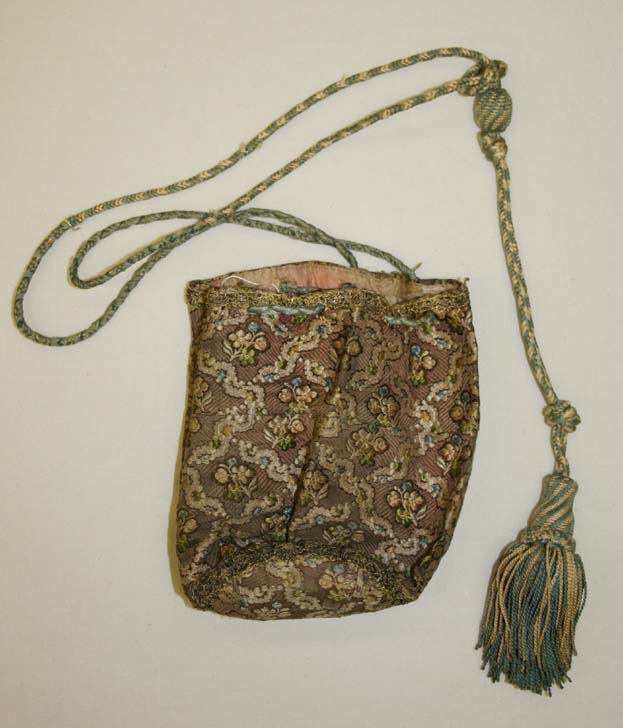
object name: reticule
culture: european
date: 1701-1800